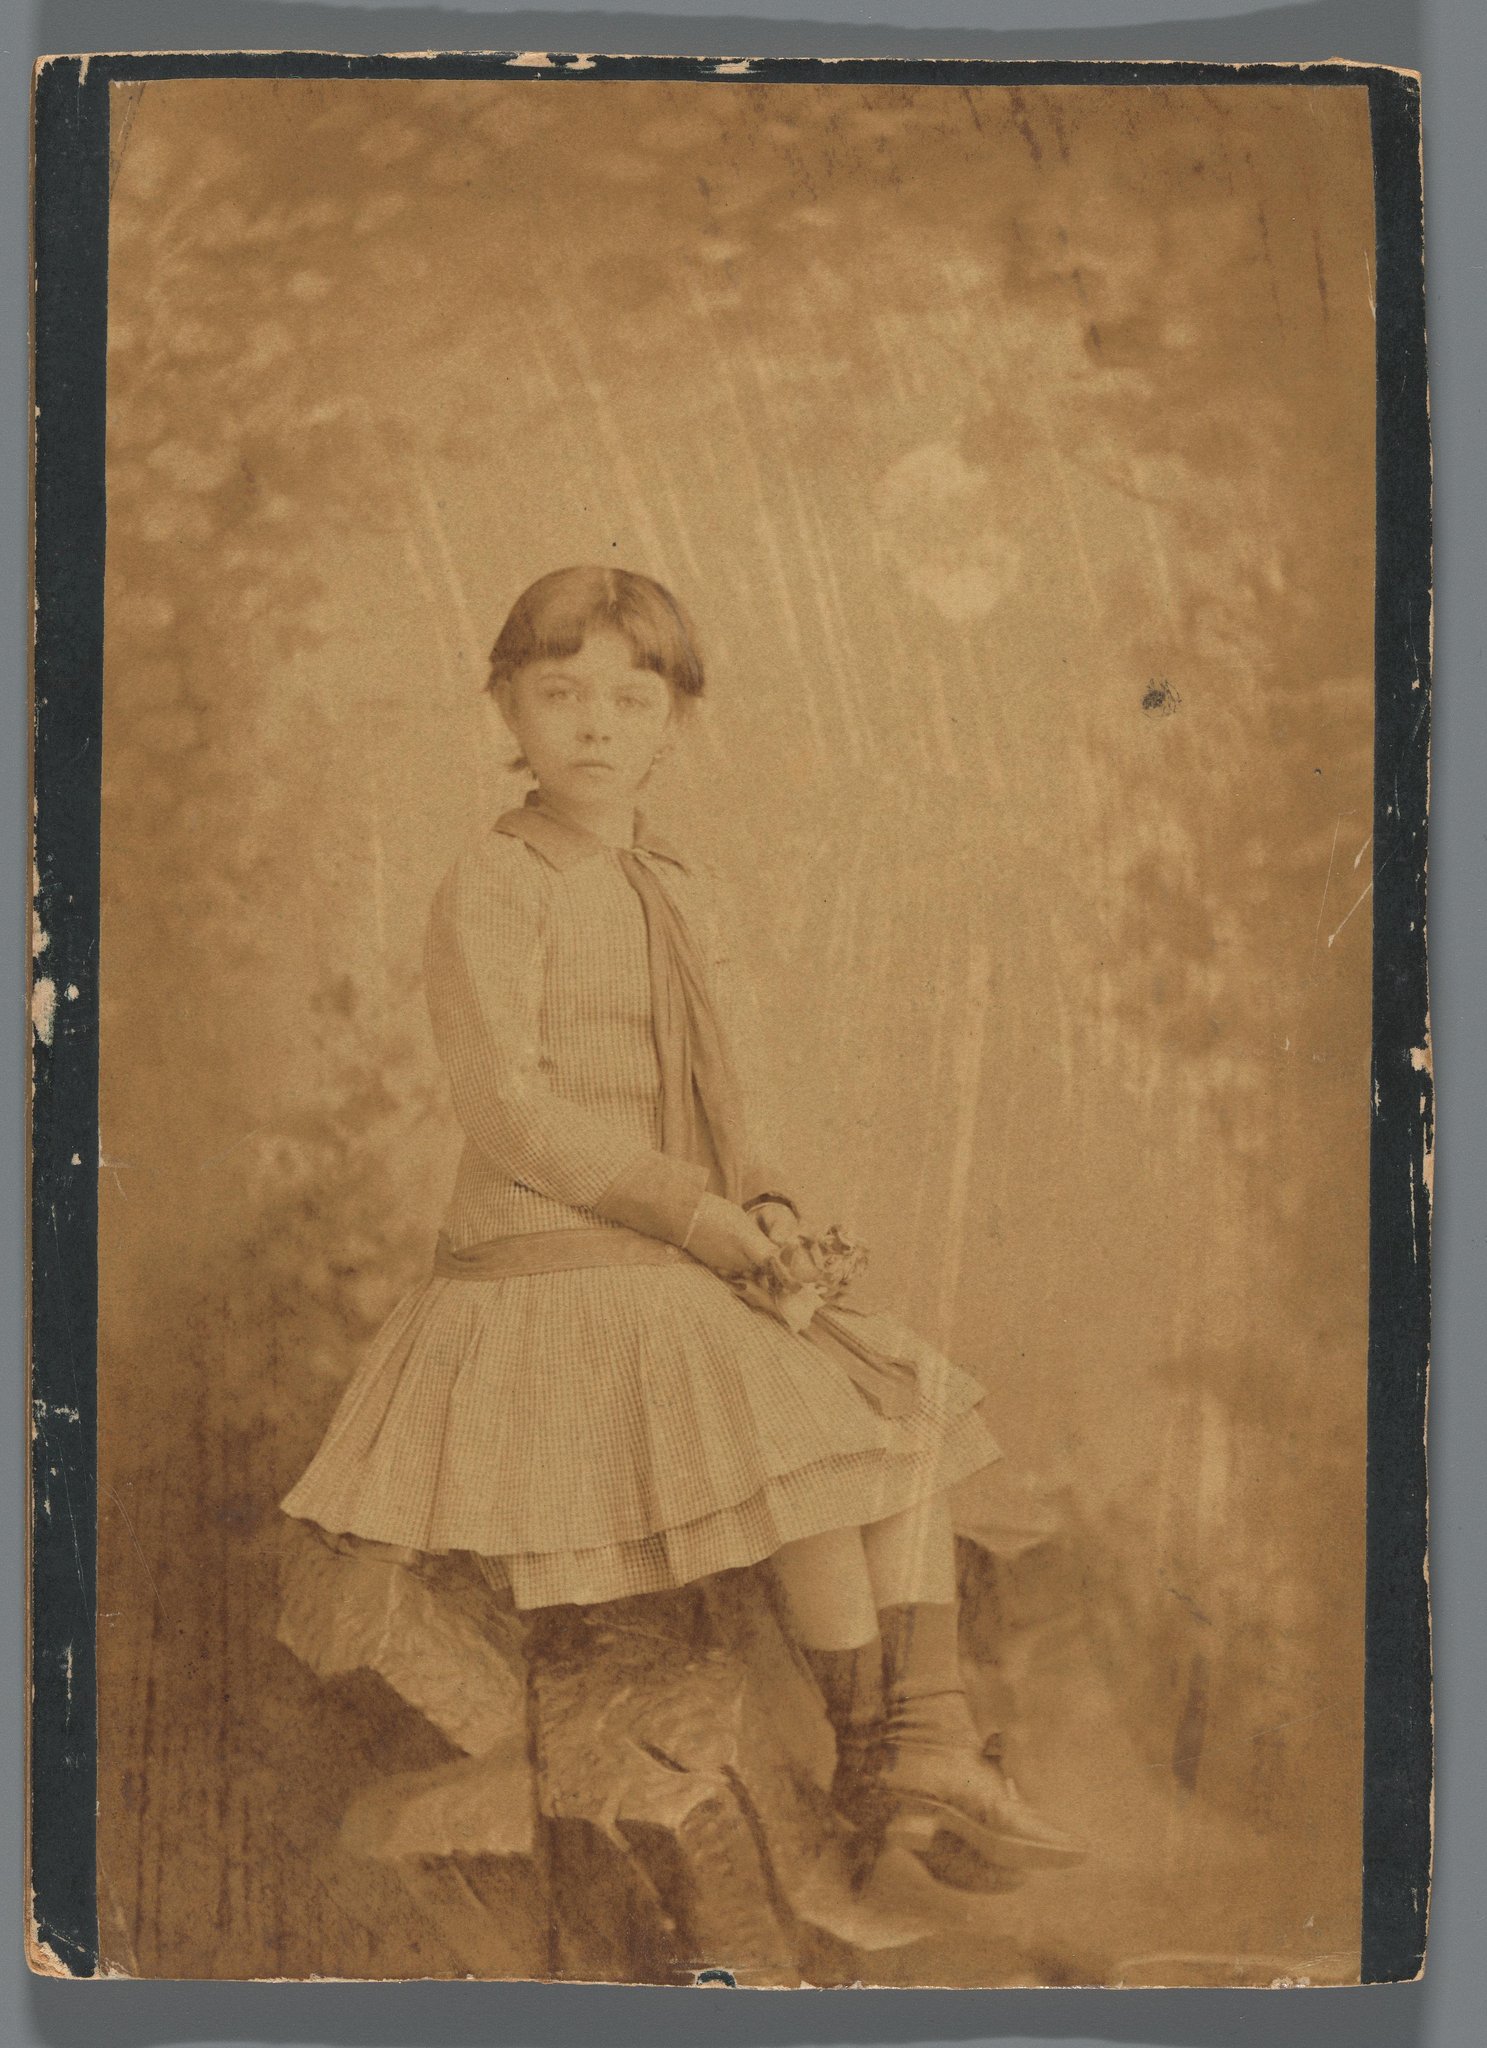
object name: photograph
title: Studioportret van meisje (A.C.M. Geertsema)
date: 1860-1900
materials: cardboard, photographic support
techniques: albumen print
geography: the hague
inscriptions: name